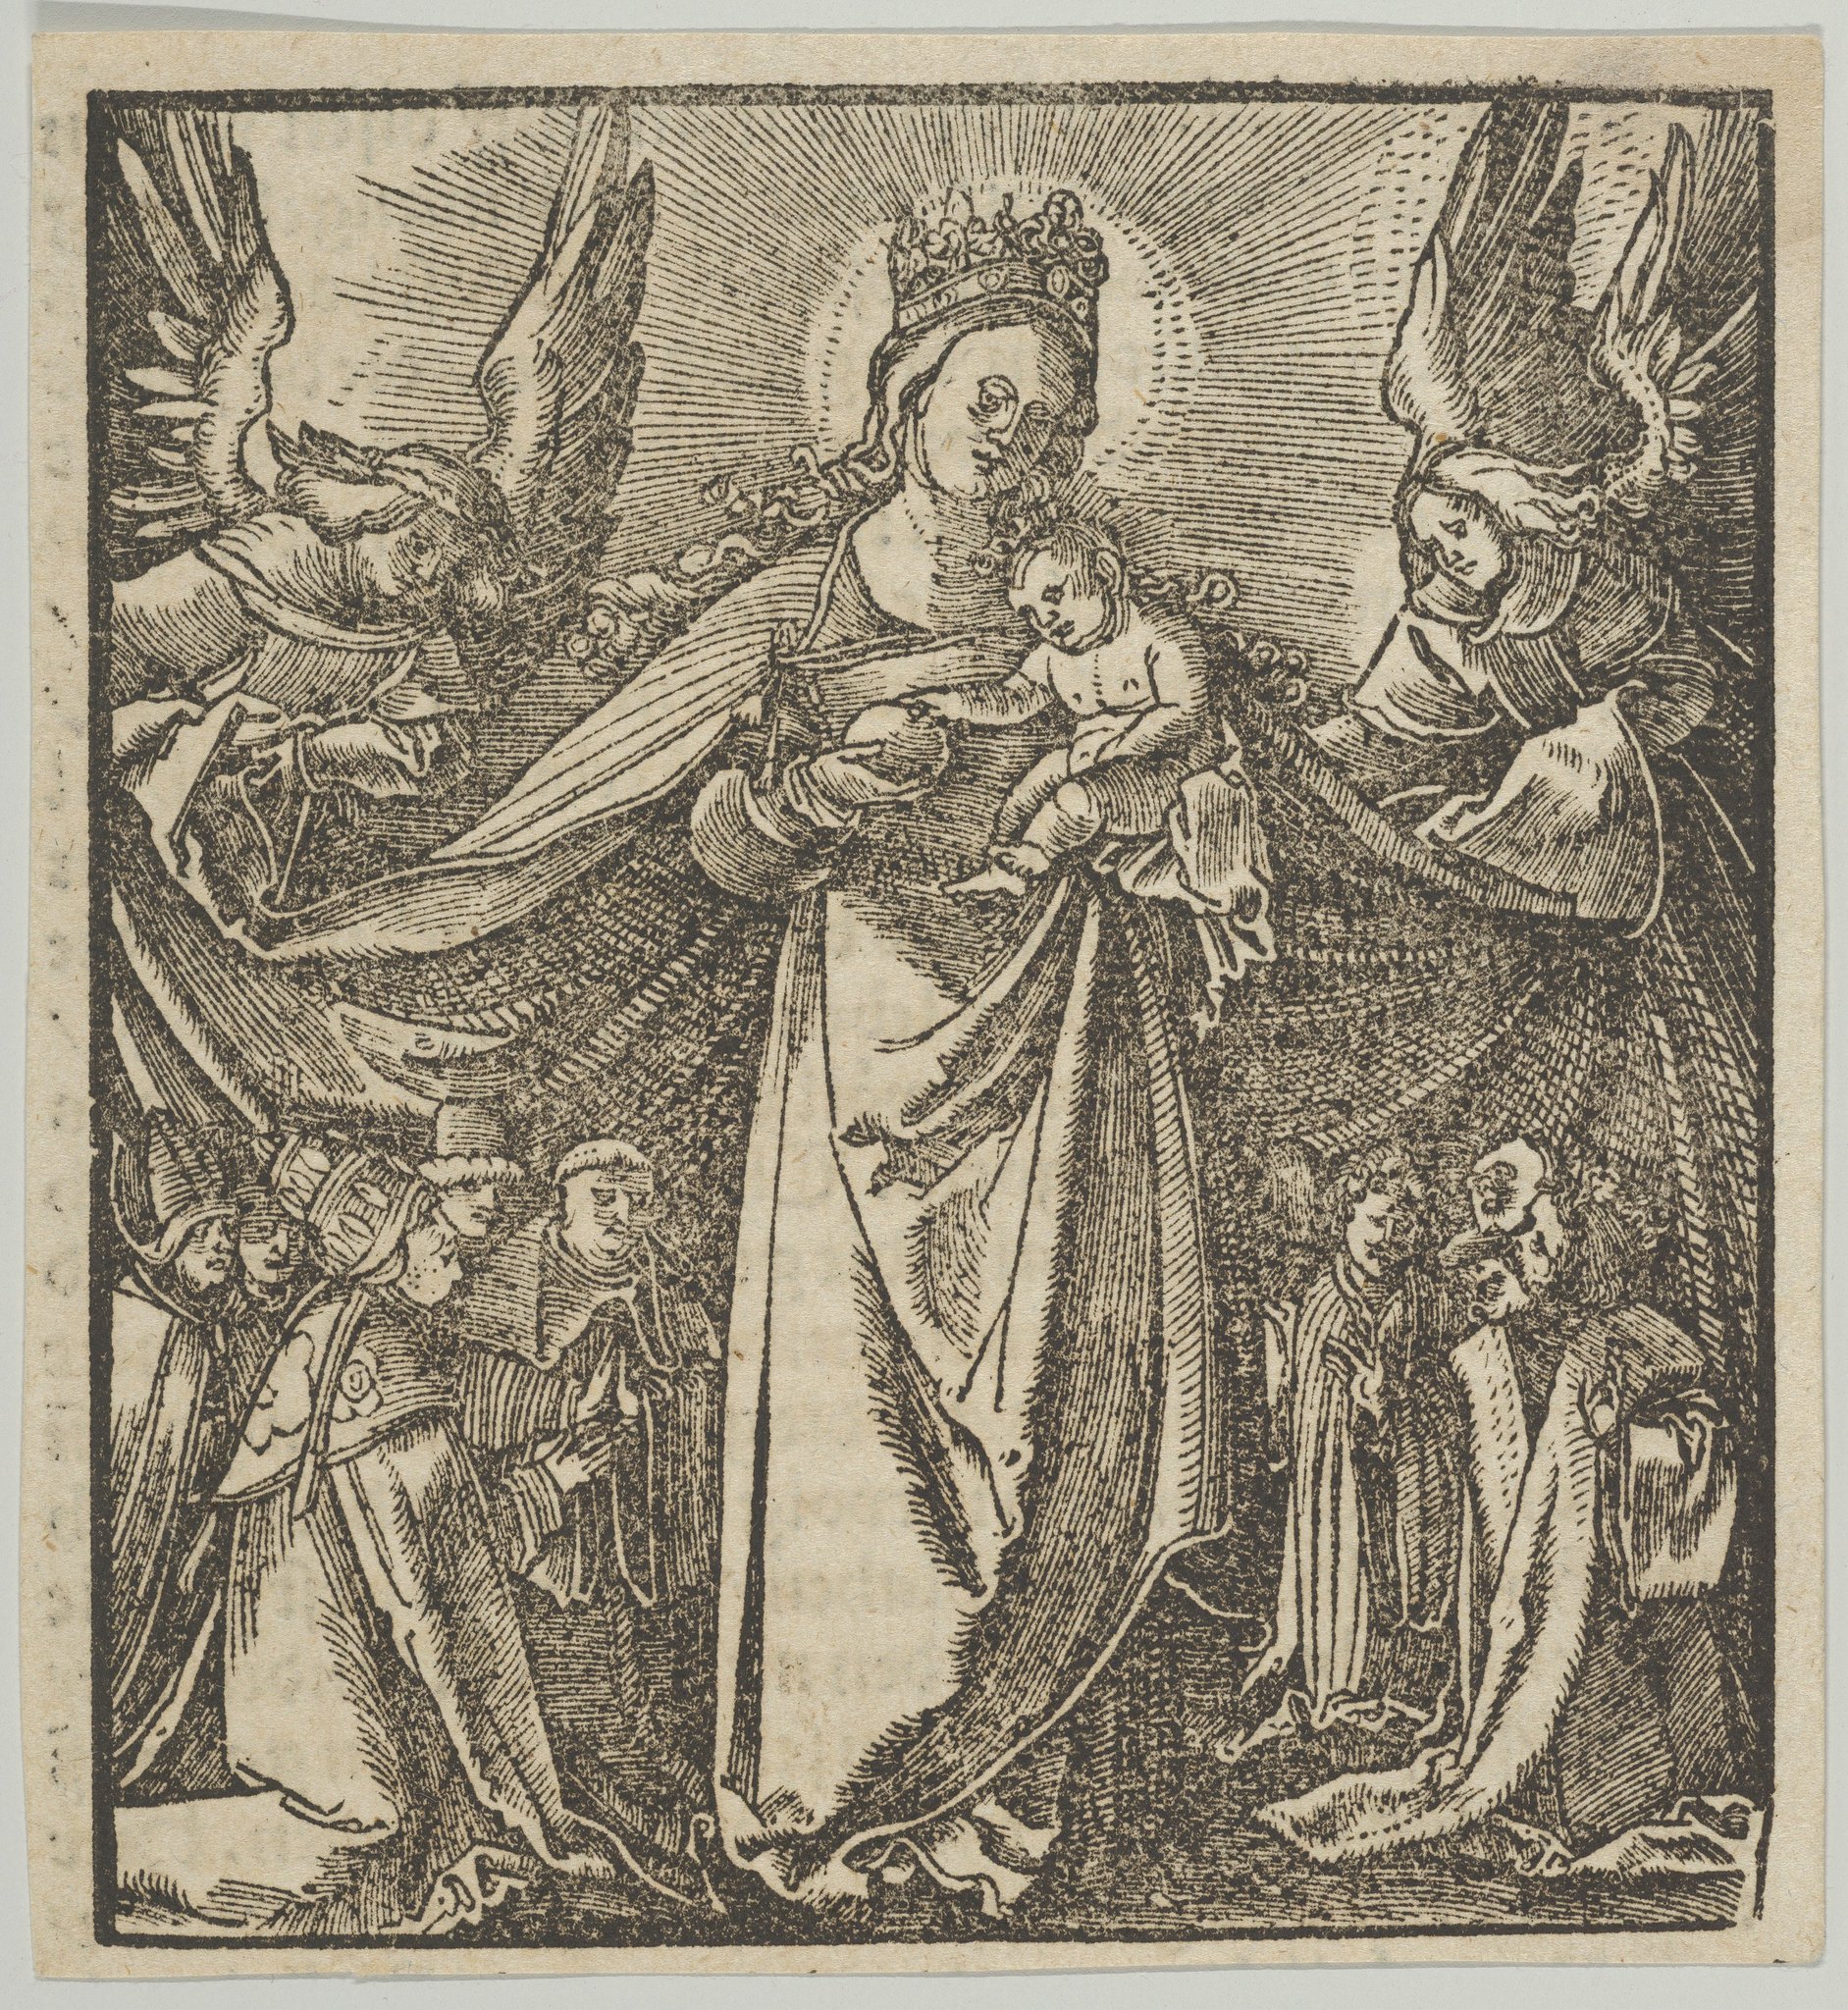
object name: print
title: The Madonna of Mercy, from Hymmelwagen auff dem, wer wol lebt...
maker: hans schäufelein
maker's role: artist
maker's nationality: german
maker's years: 1480-1540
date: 1517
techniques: woodcut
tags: human figures,angels,madonna and child